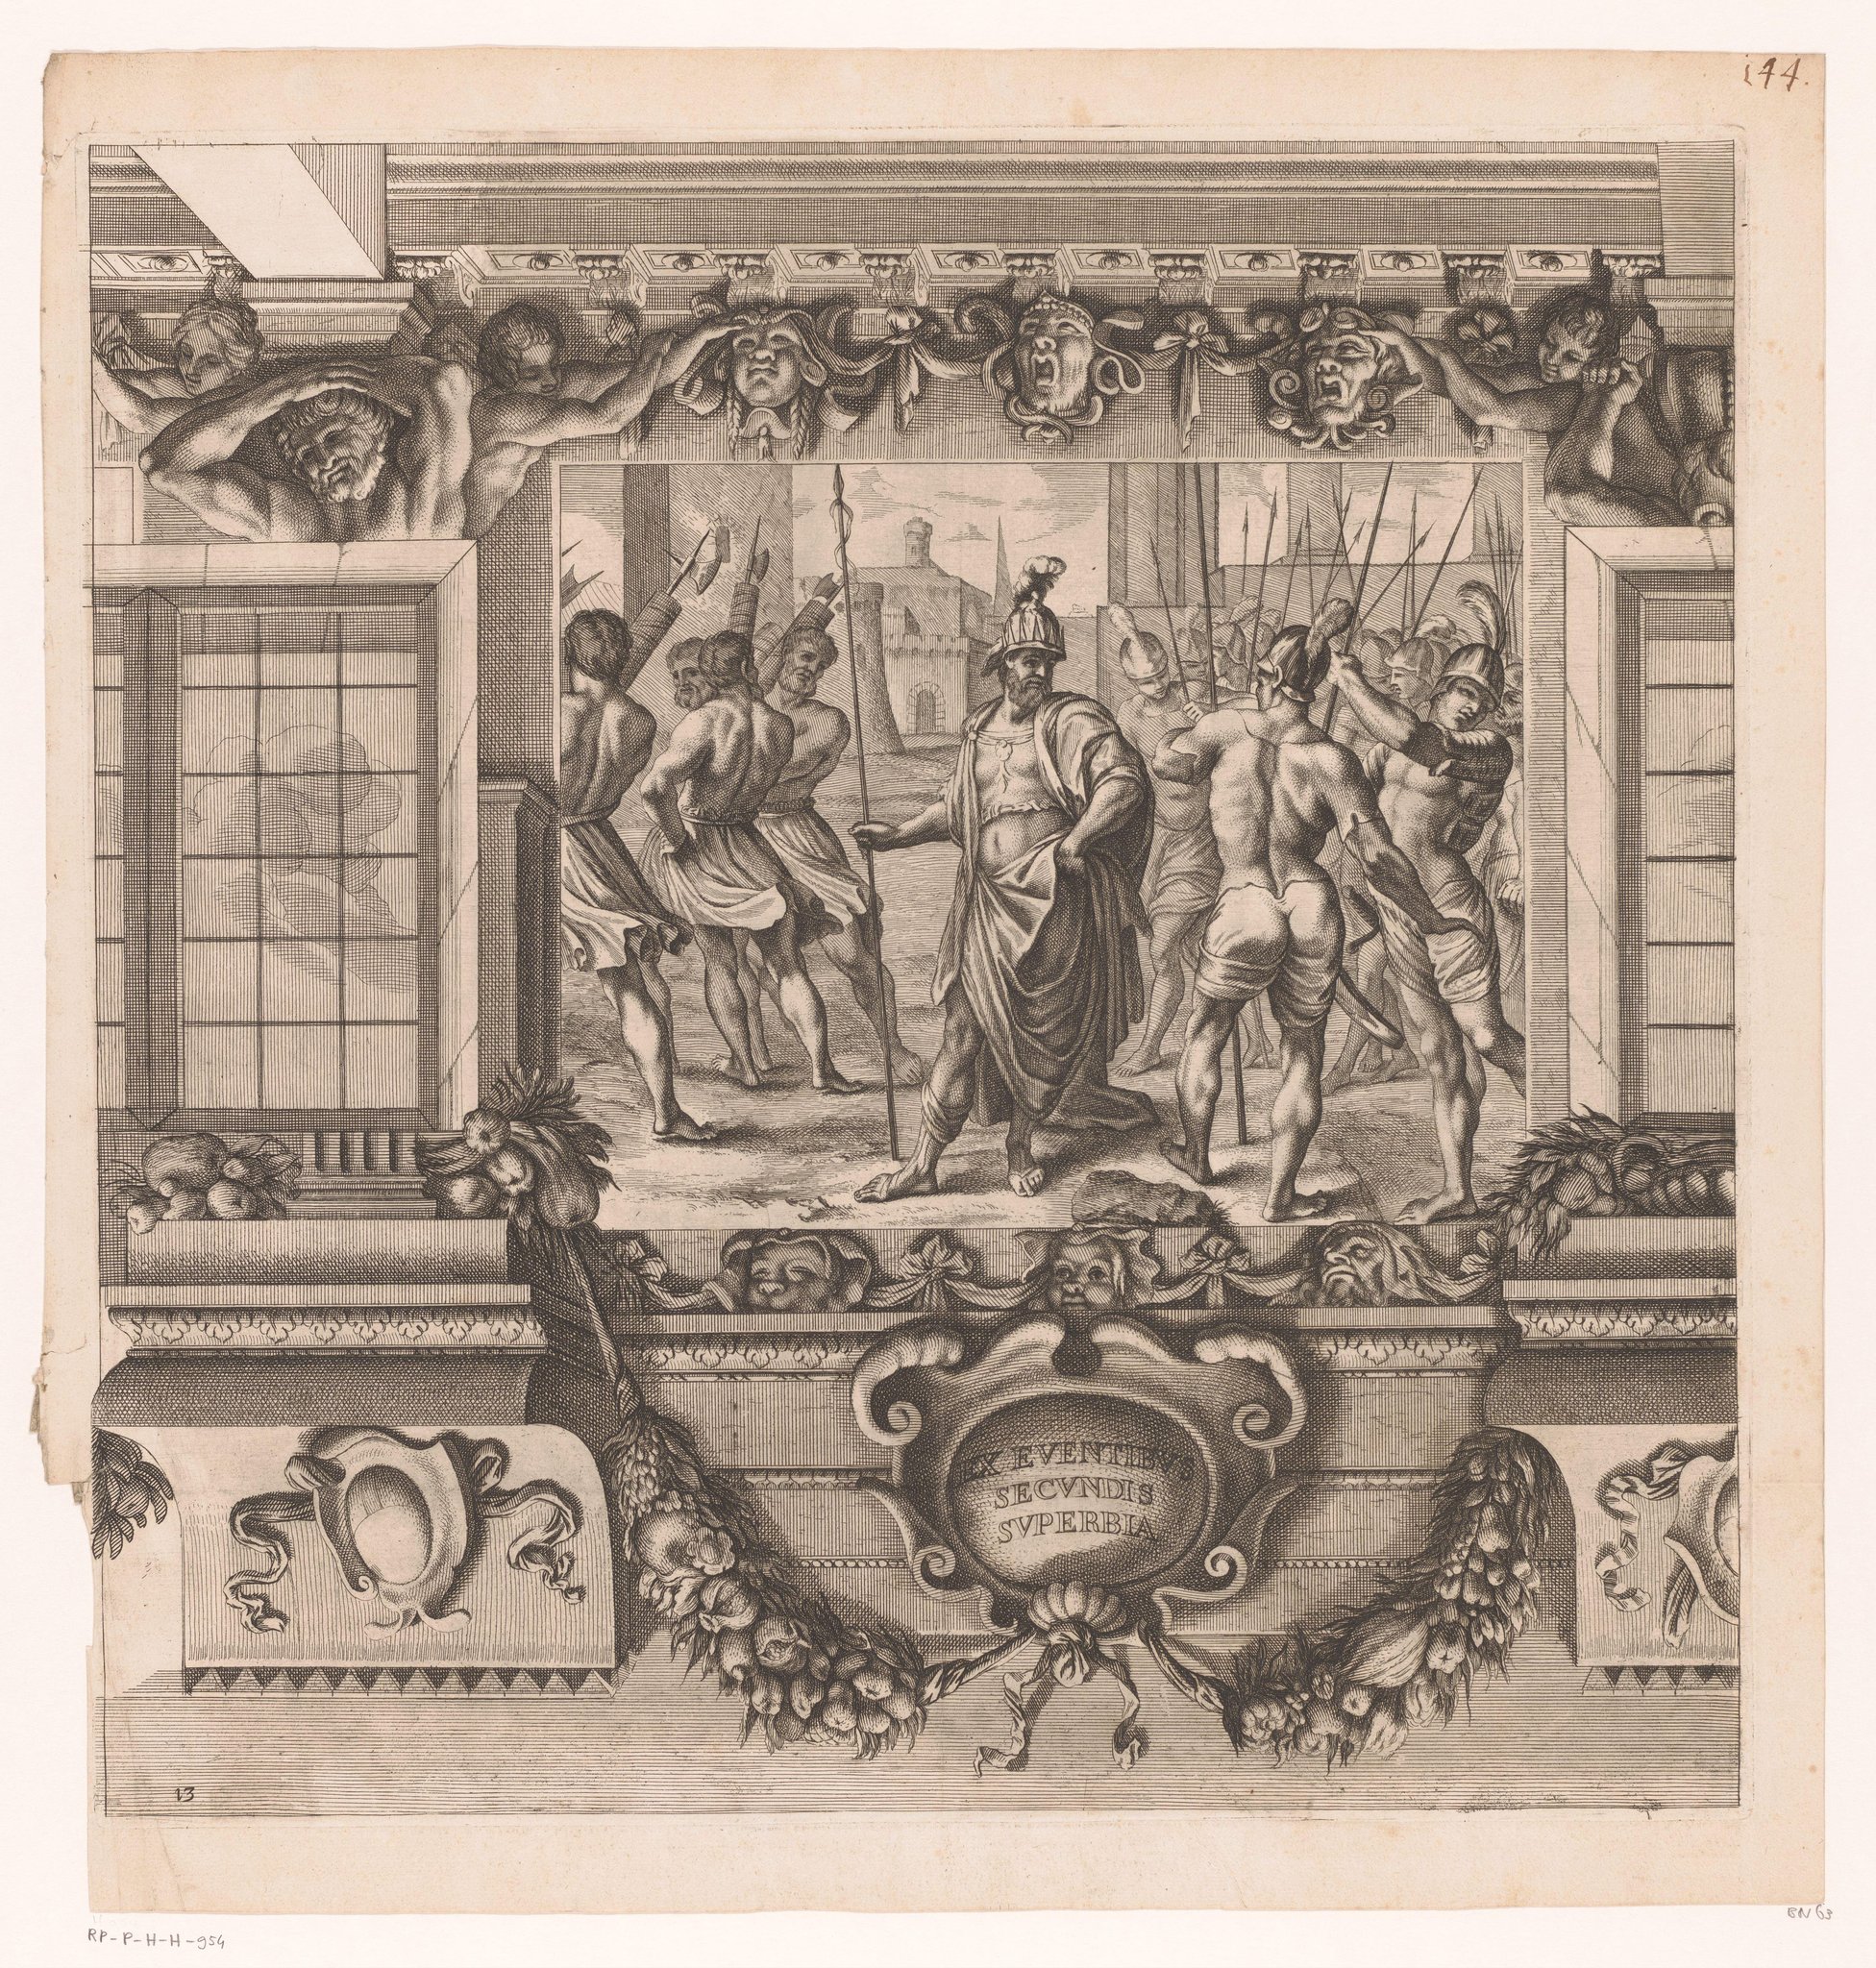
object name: print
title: Verhaal van Romulus en Remus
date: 1659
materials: paper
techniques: engraving, etching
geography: paris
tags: romulus as king of rome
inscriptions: number: ‘144.’, collector's mark: Lugt 11, number: ‘145.’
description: Maakt deel uit van een 14-delige serie met scènes uit het verhaal van Romulus en Remus naar ontwerpen door de familie Carracci voor het Palazzo Magnani te Bologna. Prent 1 t/m 7 zijn in prent gebracht door Lepautre en Boulanger en prent 8 t/m 14 door De Châtillon.